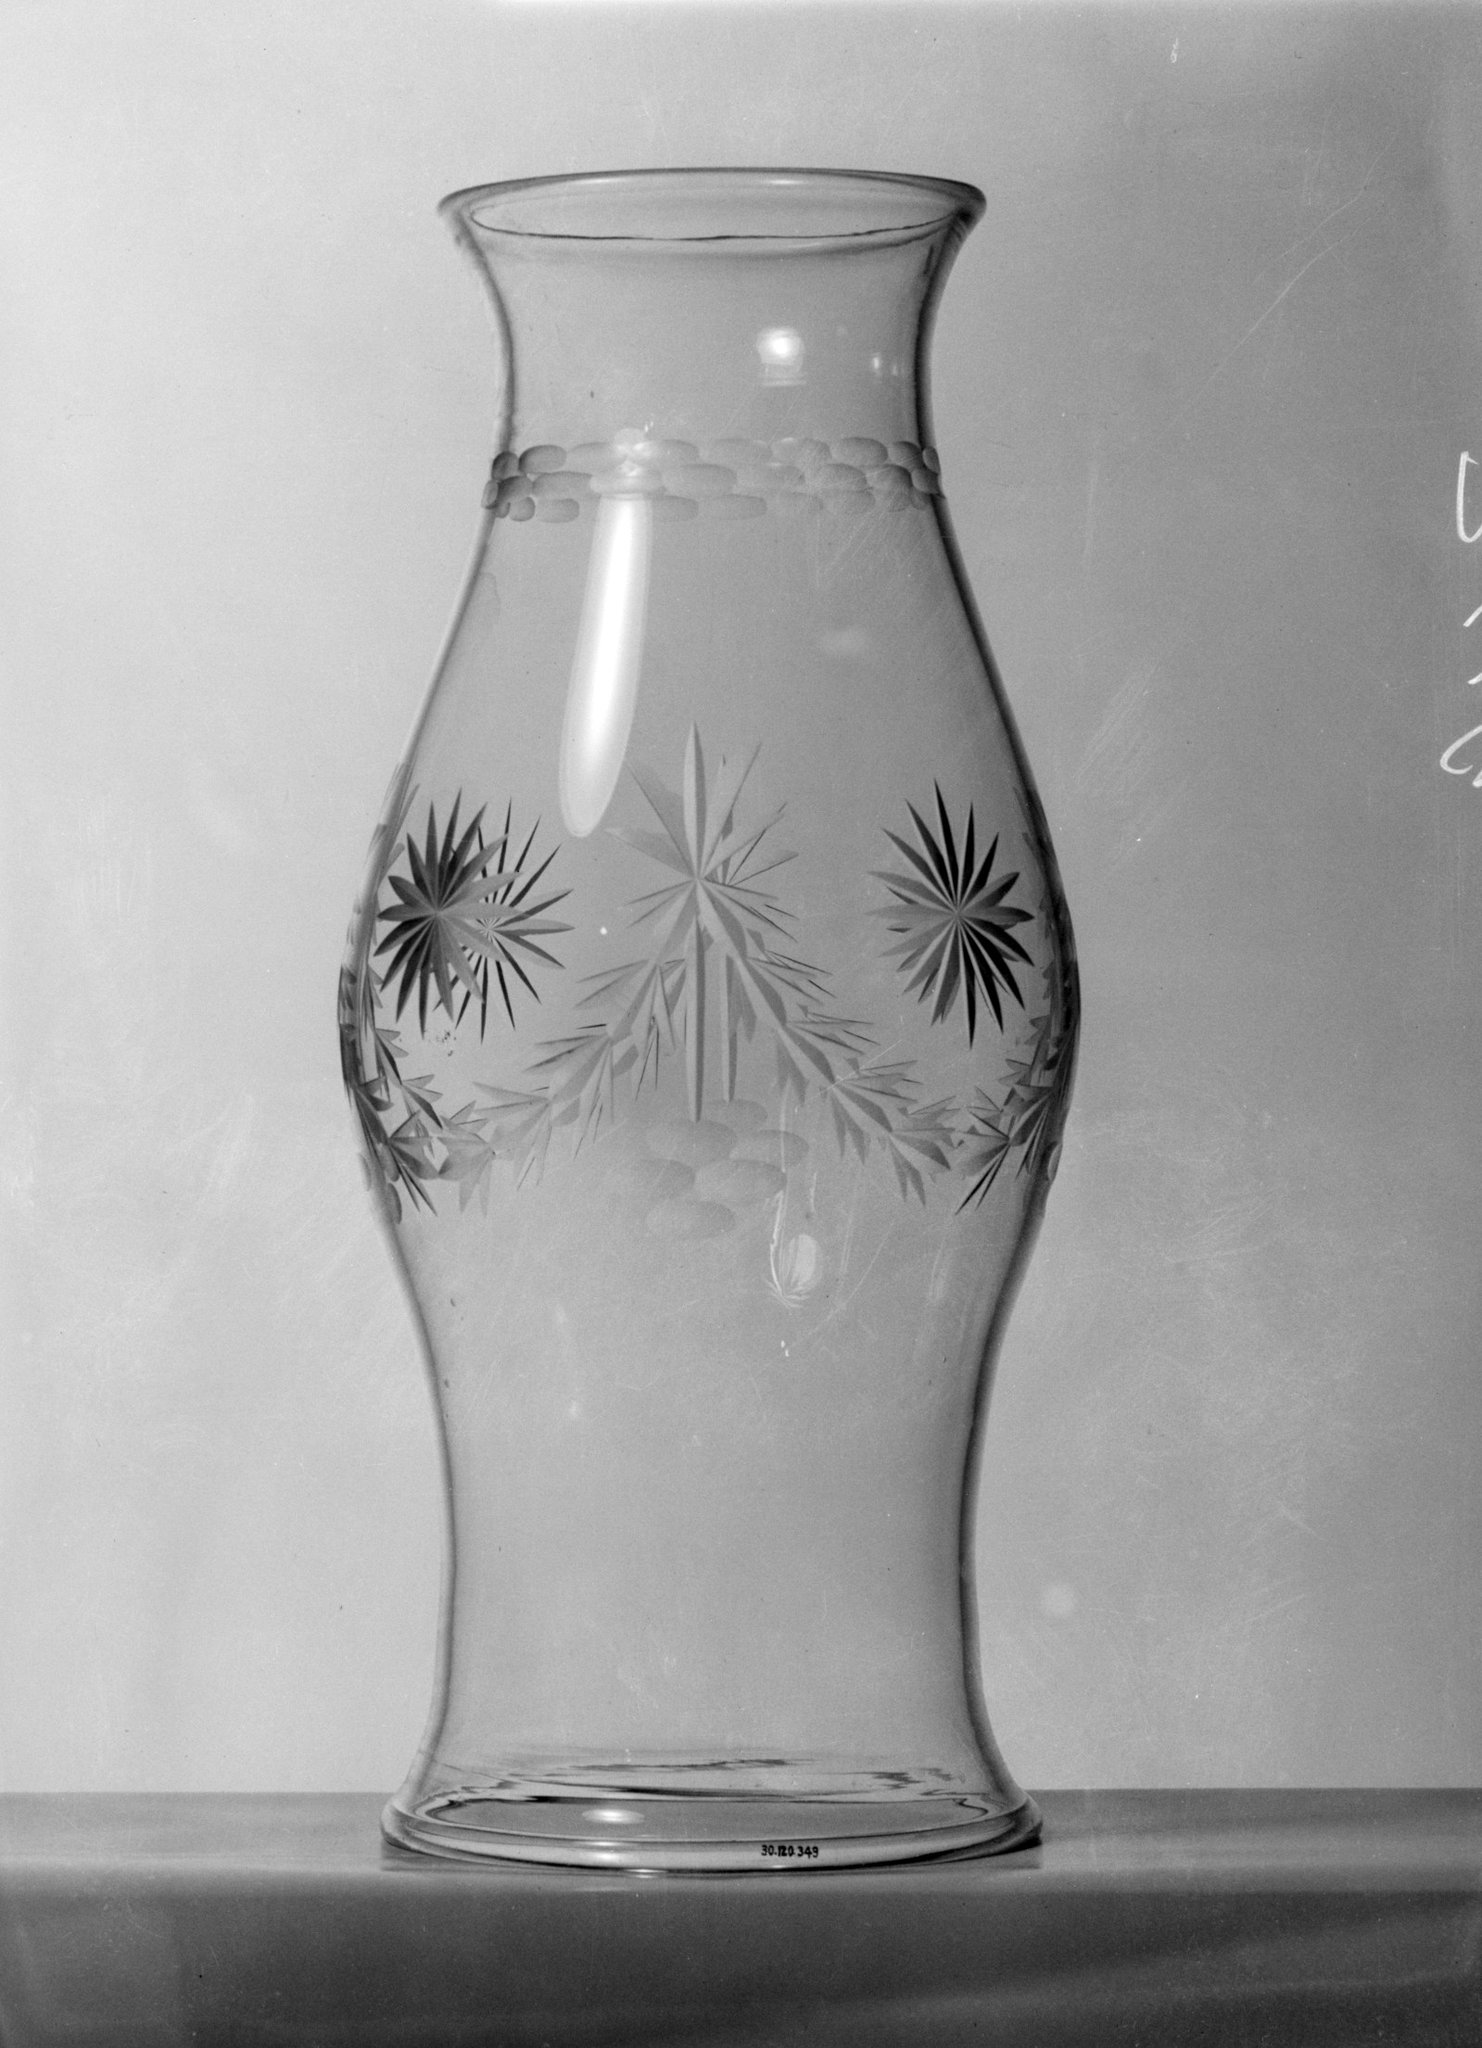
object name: hurricane shade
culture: british or irish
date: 1800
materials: glass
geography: ireland